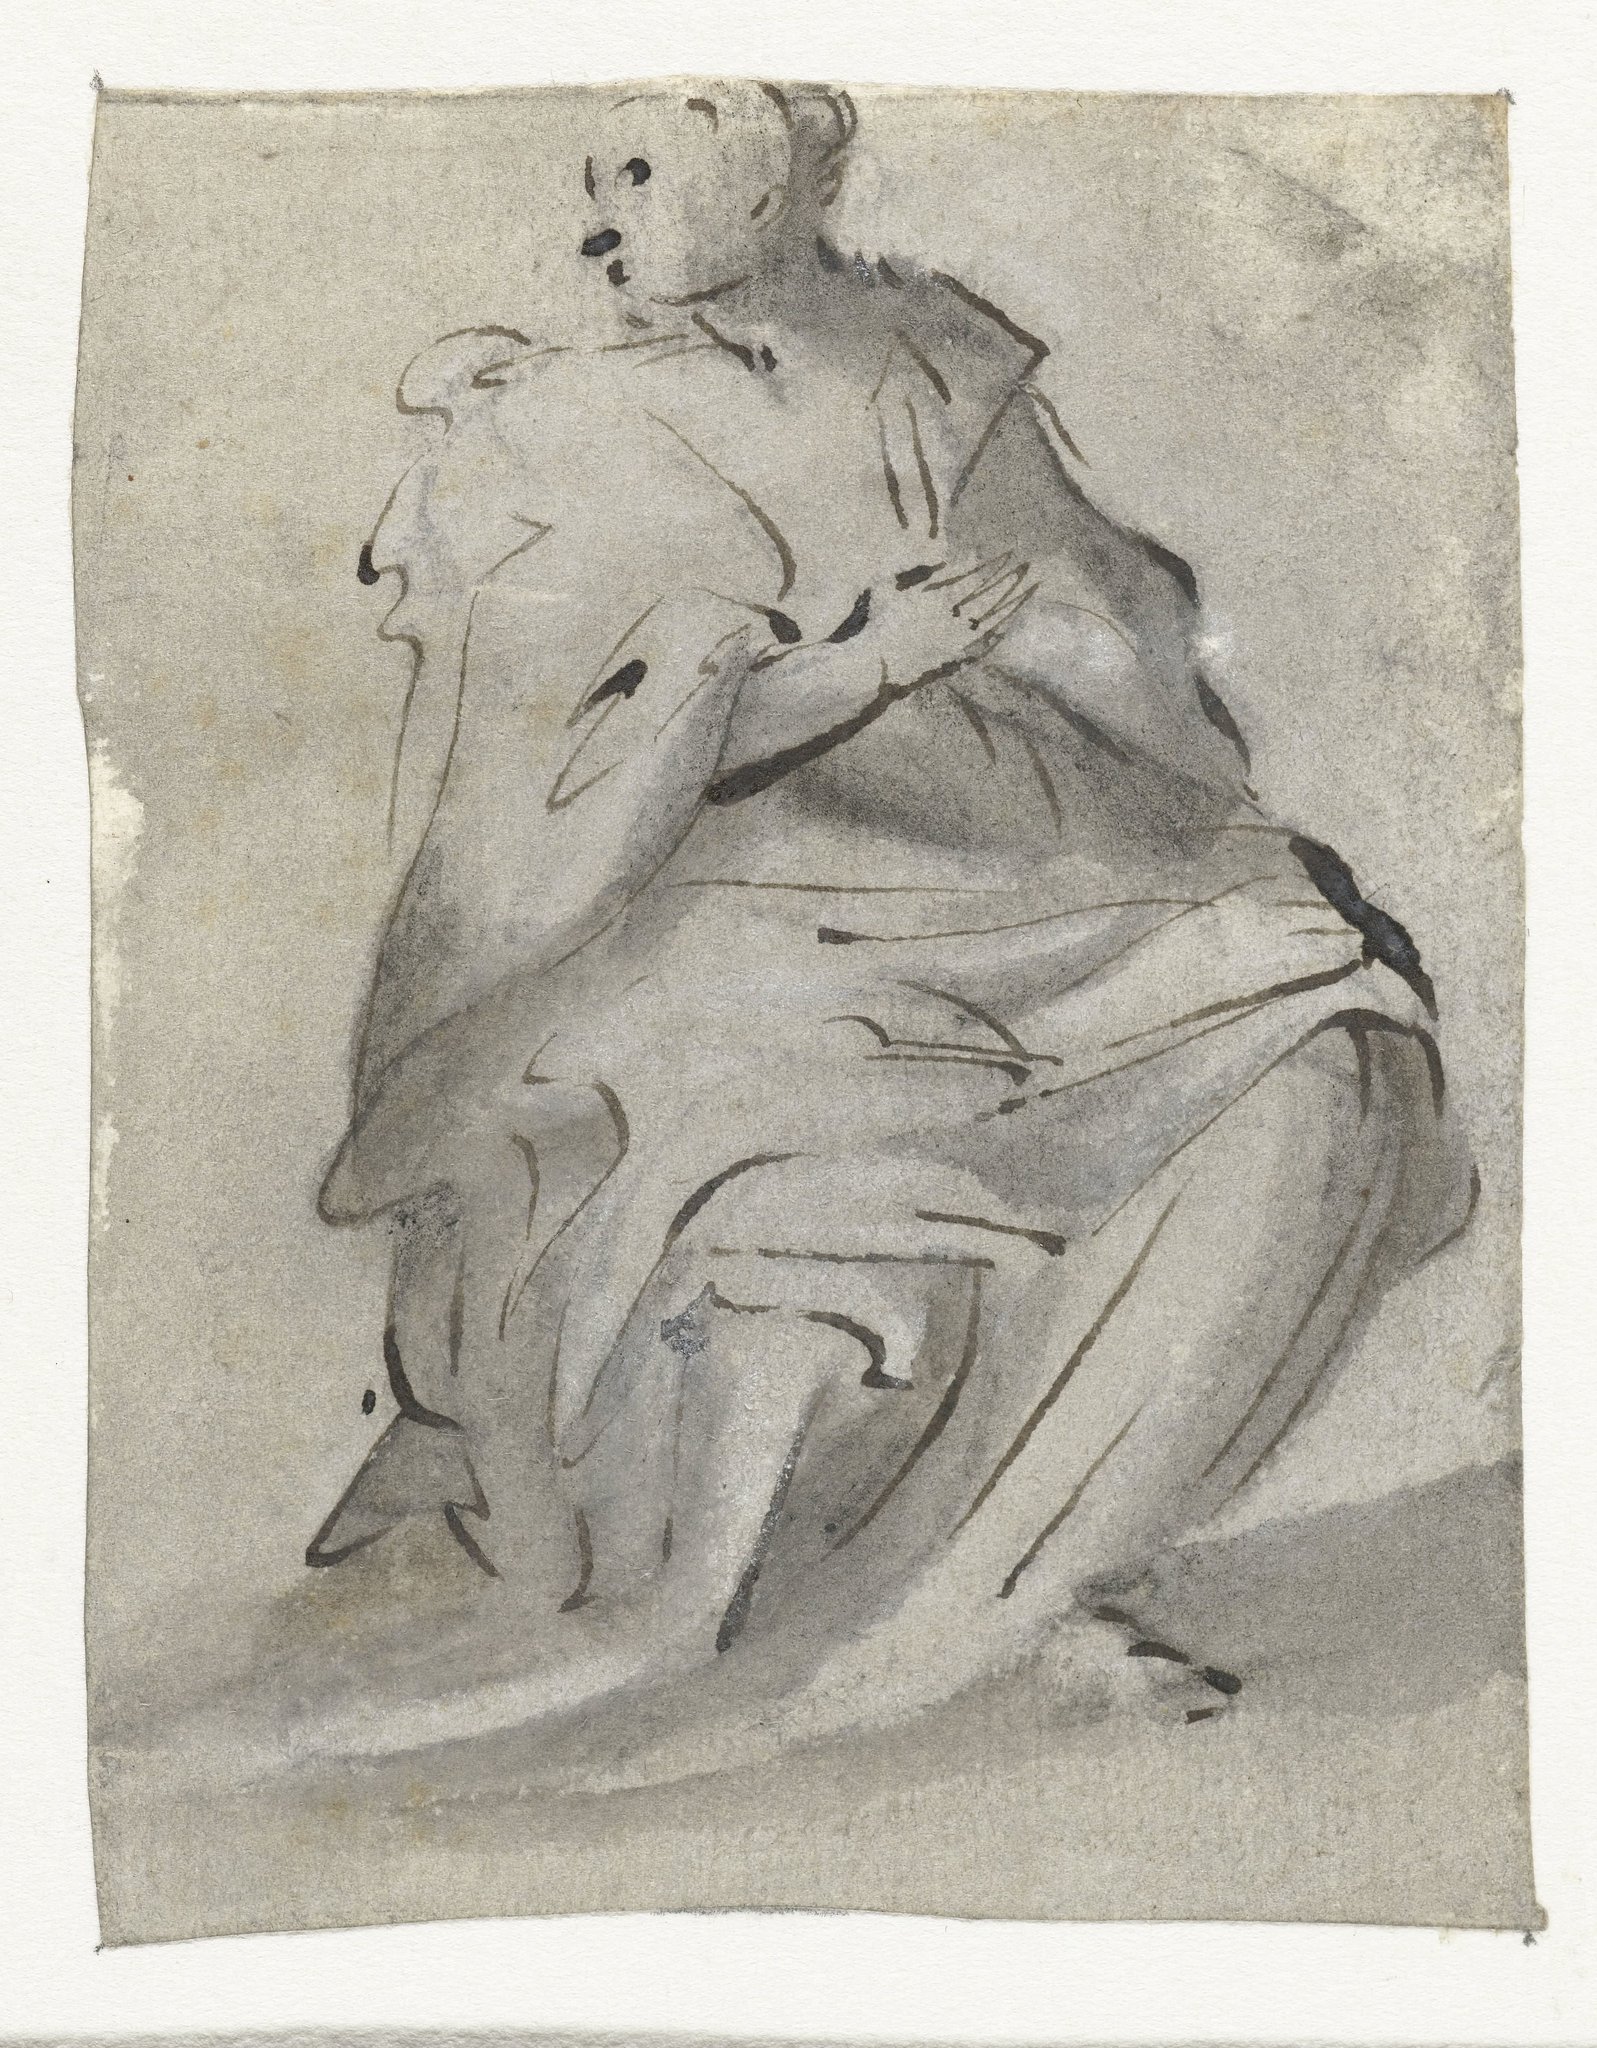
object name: drawing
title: Zittende vrouw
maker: moses ter borch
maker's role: draughtsman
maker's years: 1645-1667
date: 1656-1657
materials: chalk, paint, gouache, ink, paper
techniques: brush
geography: zwolle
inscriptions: annotation: ‘copie nr. Parmegiano/ zie aldaar (G)’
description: Kopie naar tekening van Polidoro da Caravaggio (RP-T-1887-A-1171), opgenomen in het bezit van de familie Ter Borch (zie cat.nr. FC 44 in Drawings from the Ter Borch studio estate).